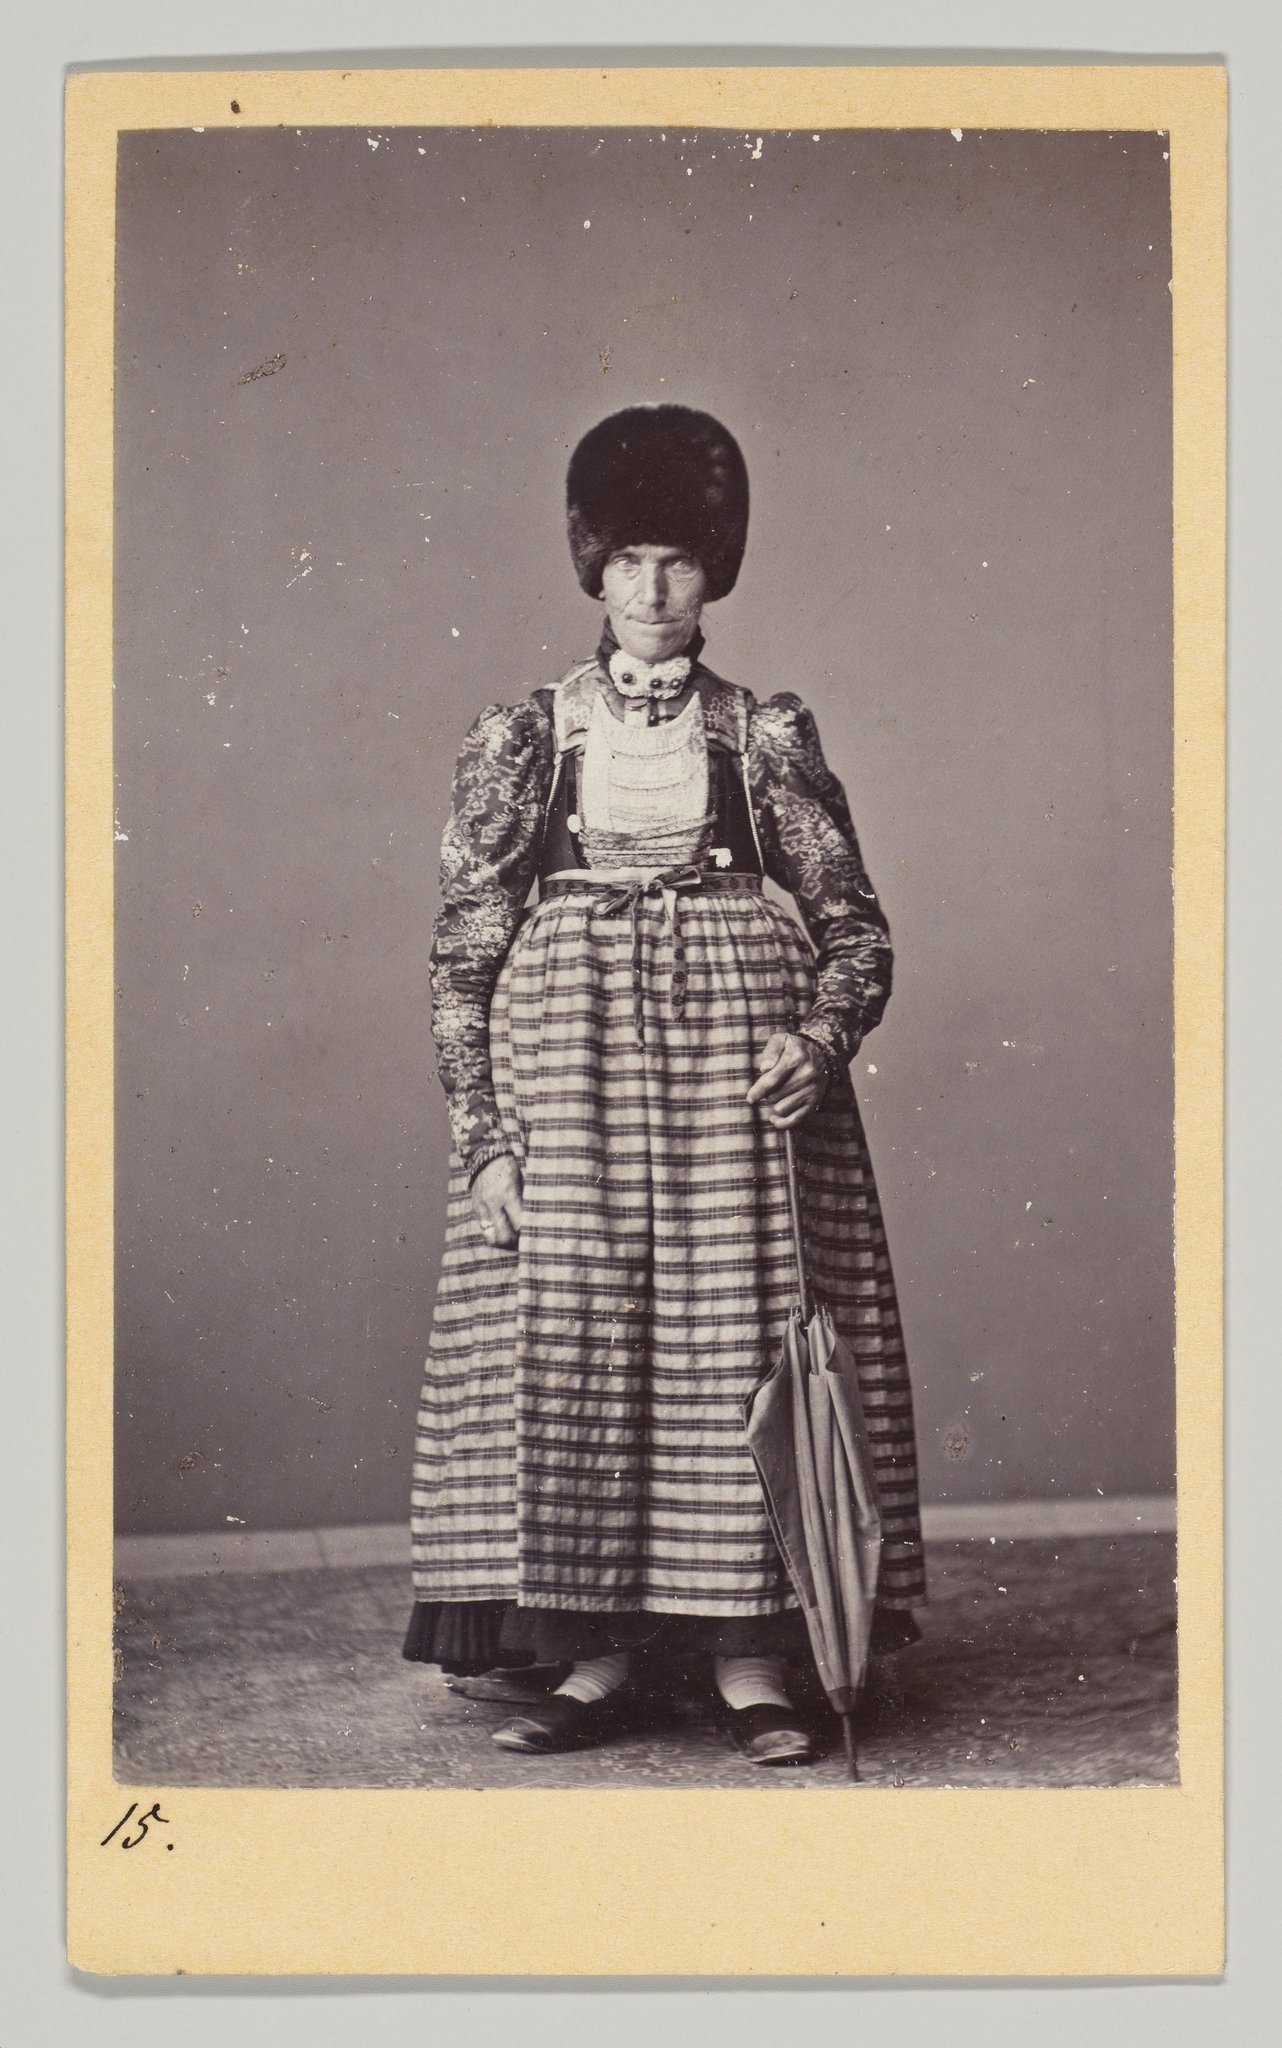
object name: photograph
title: [Woman in Regional Dress, Seen From Front and Back]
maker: Anonymous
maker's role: artist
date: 1890-1899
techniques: albumen silver print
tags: portraits,women